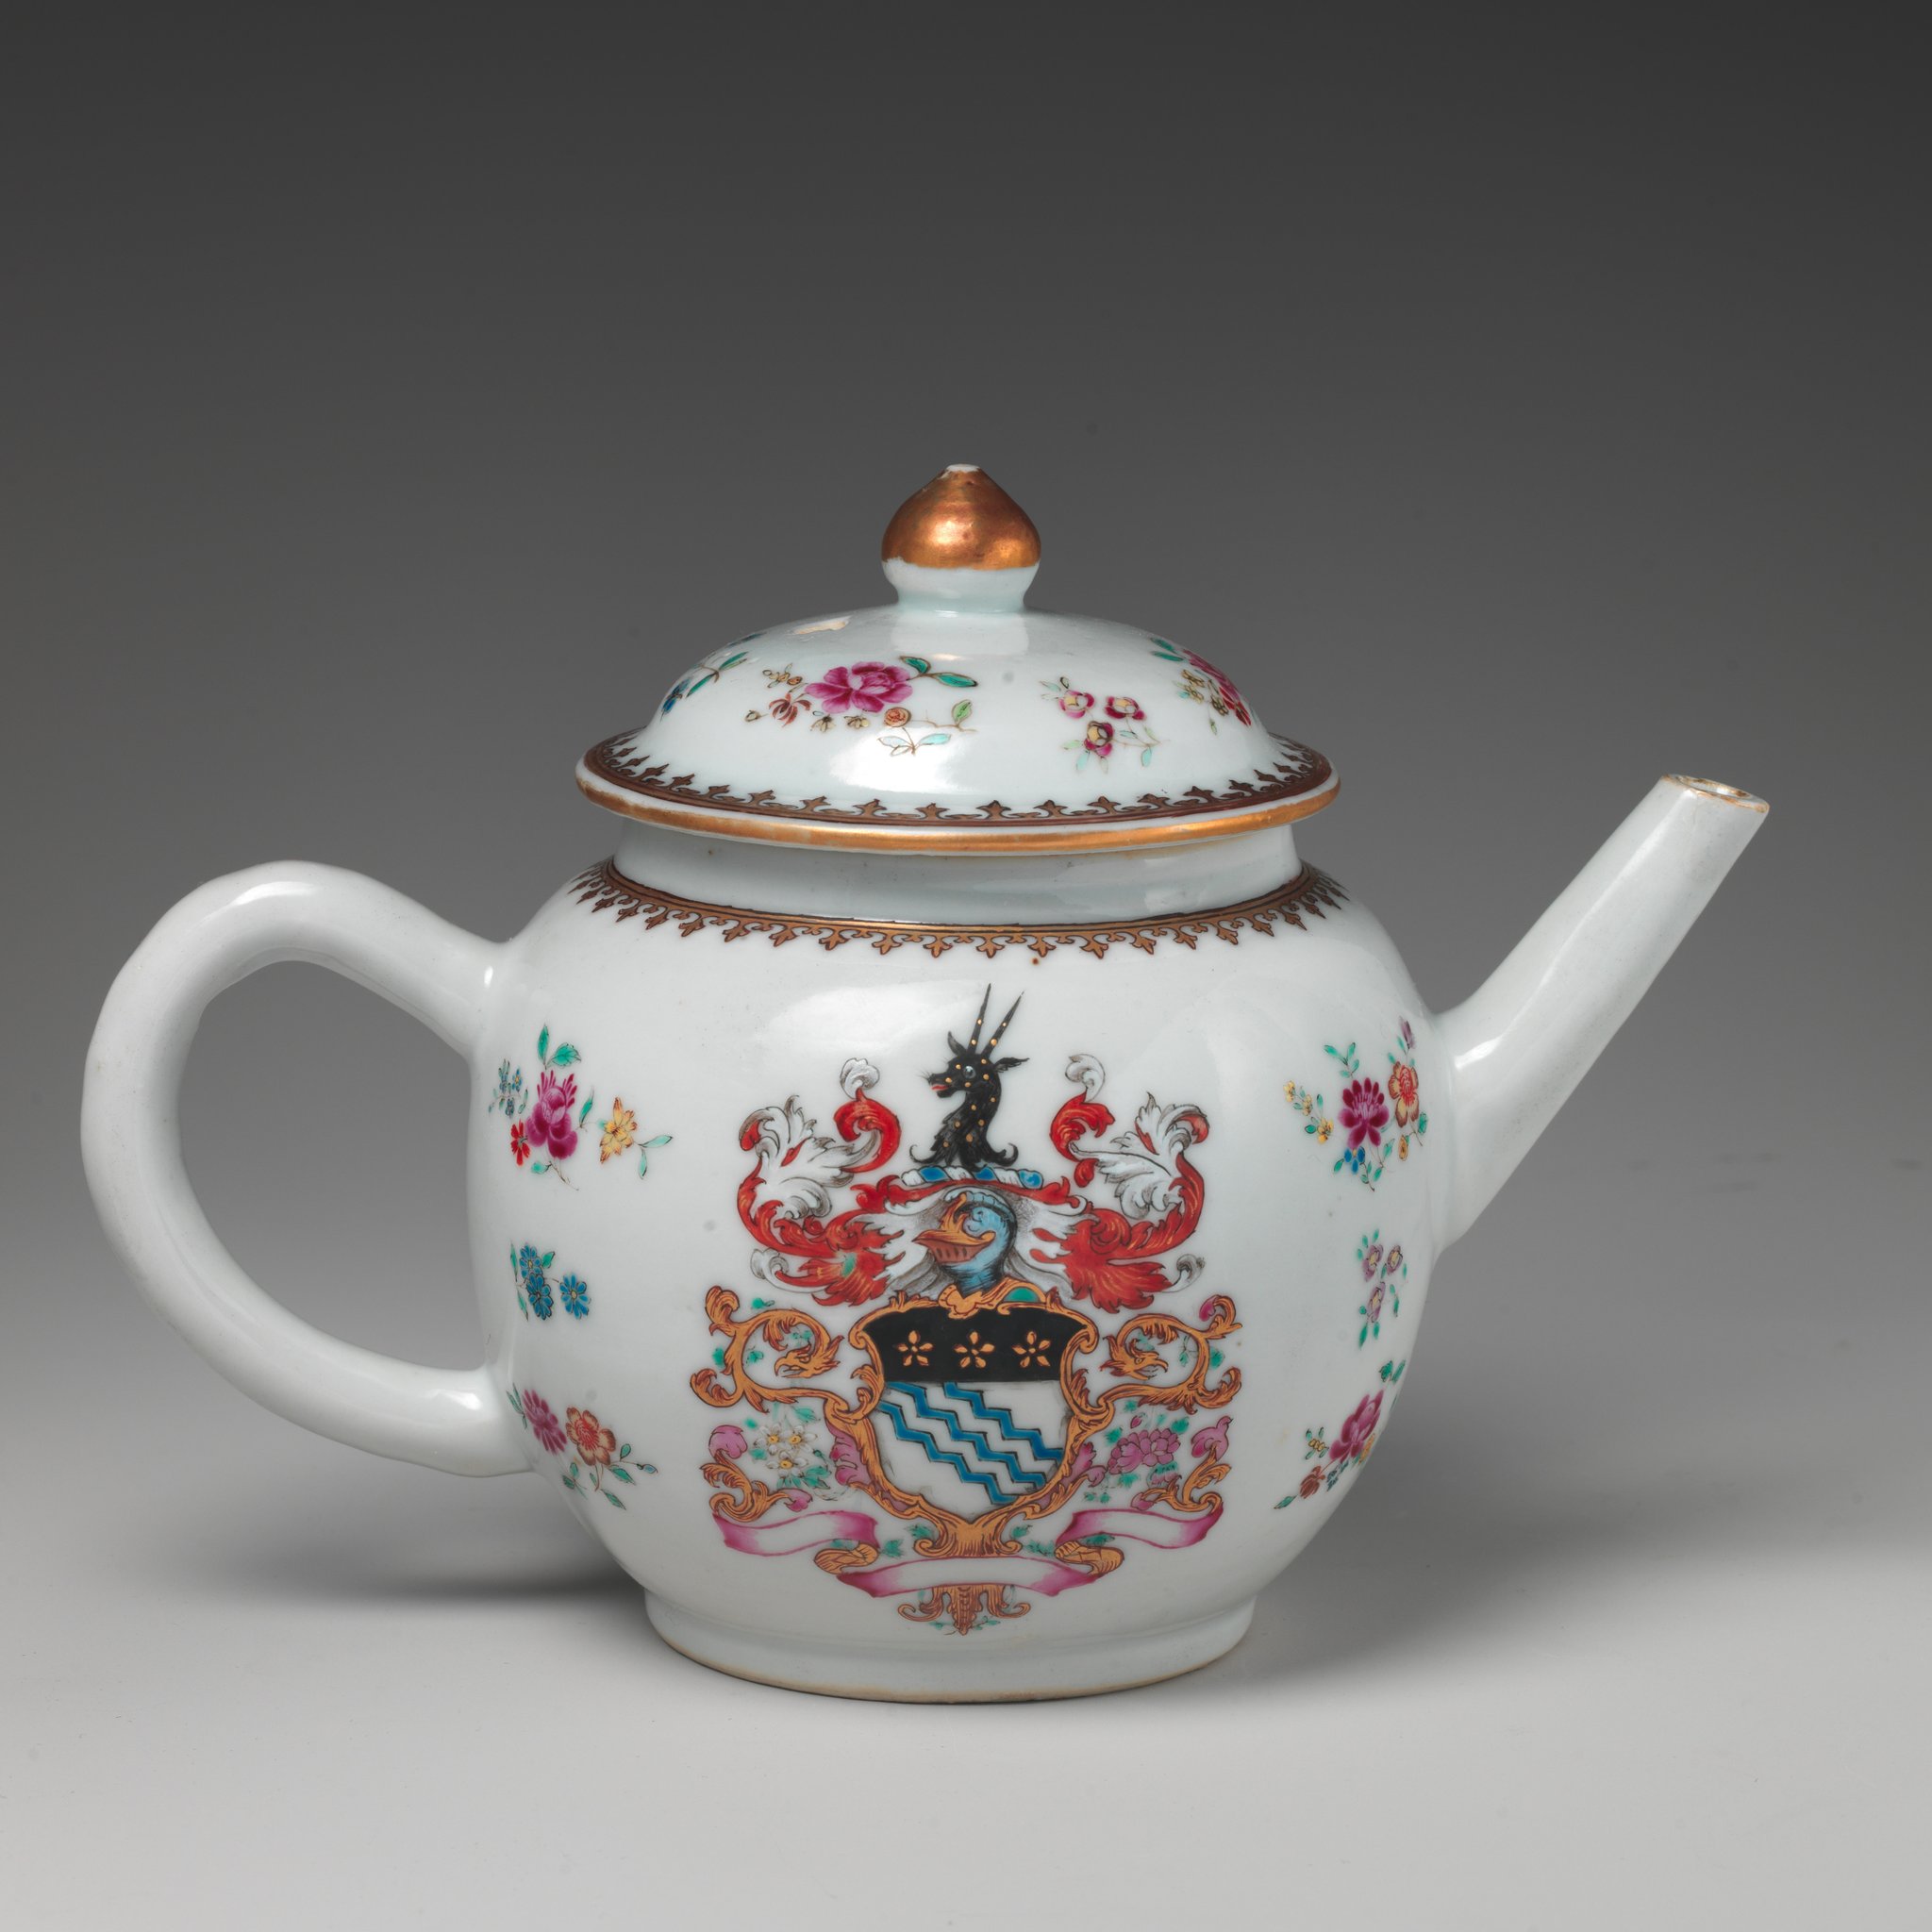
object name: teapotf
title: Teapot with armorial decoration (part of a service)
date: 1750-1760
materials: enamel, hard paste porcelain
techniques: gilding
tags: coat of arms